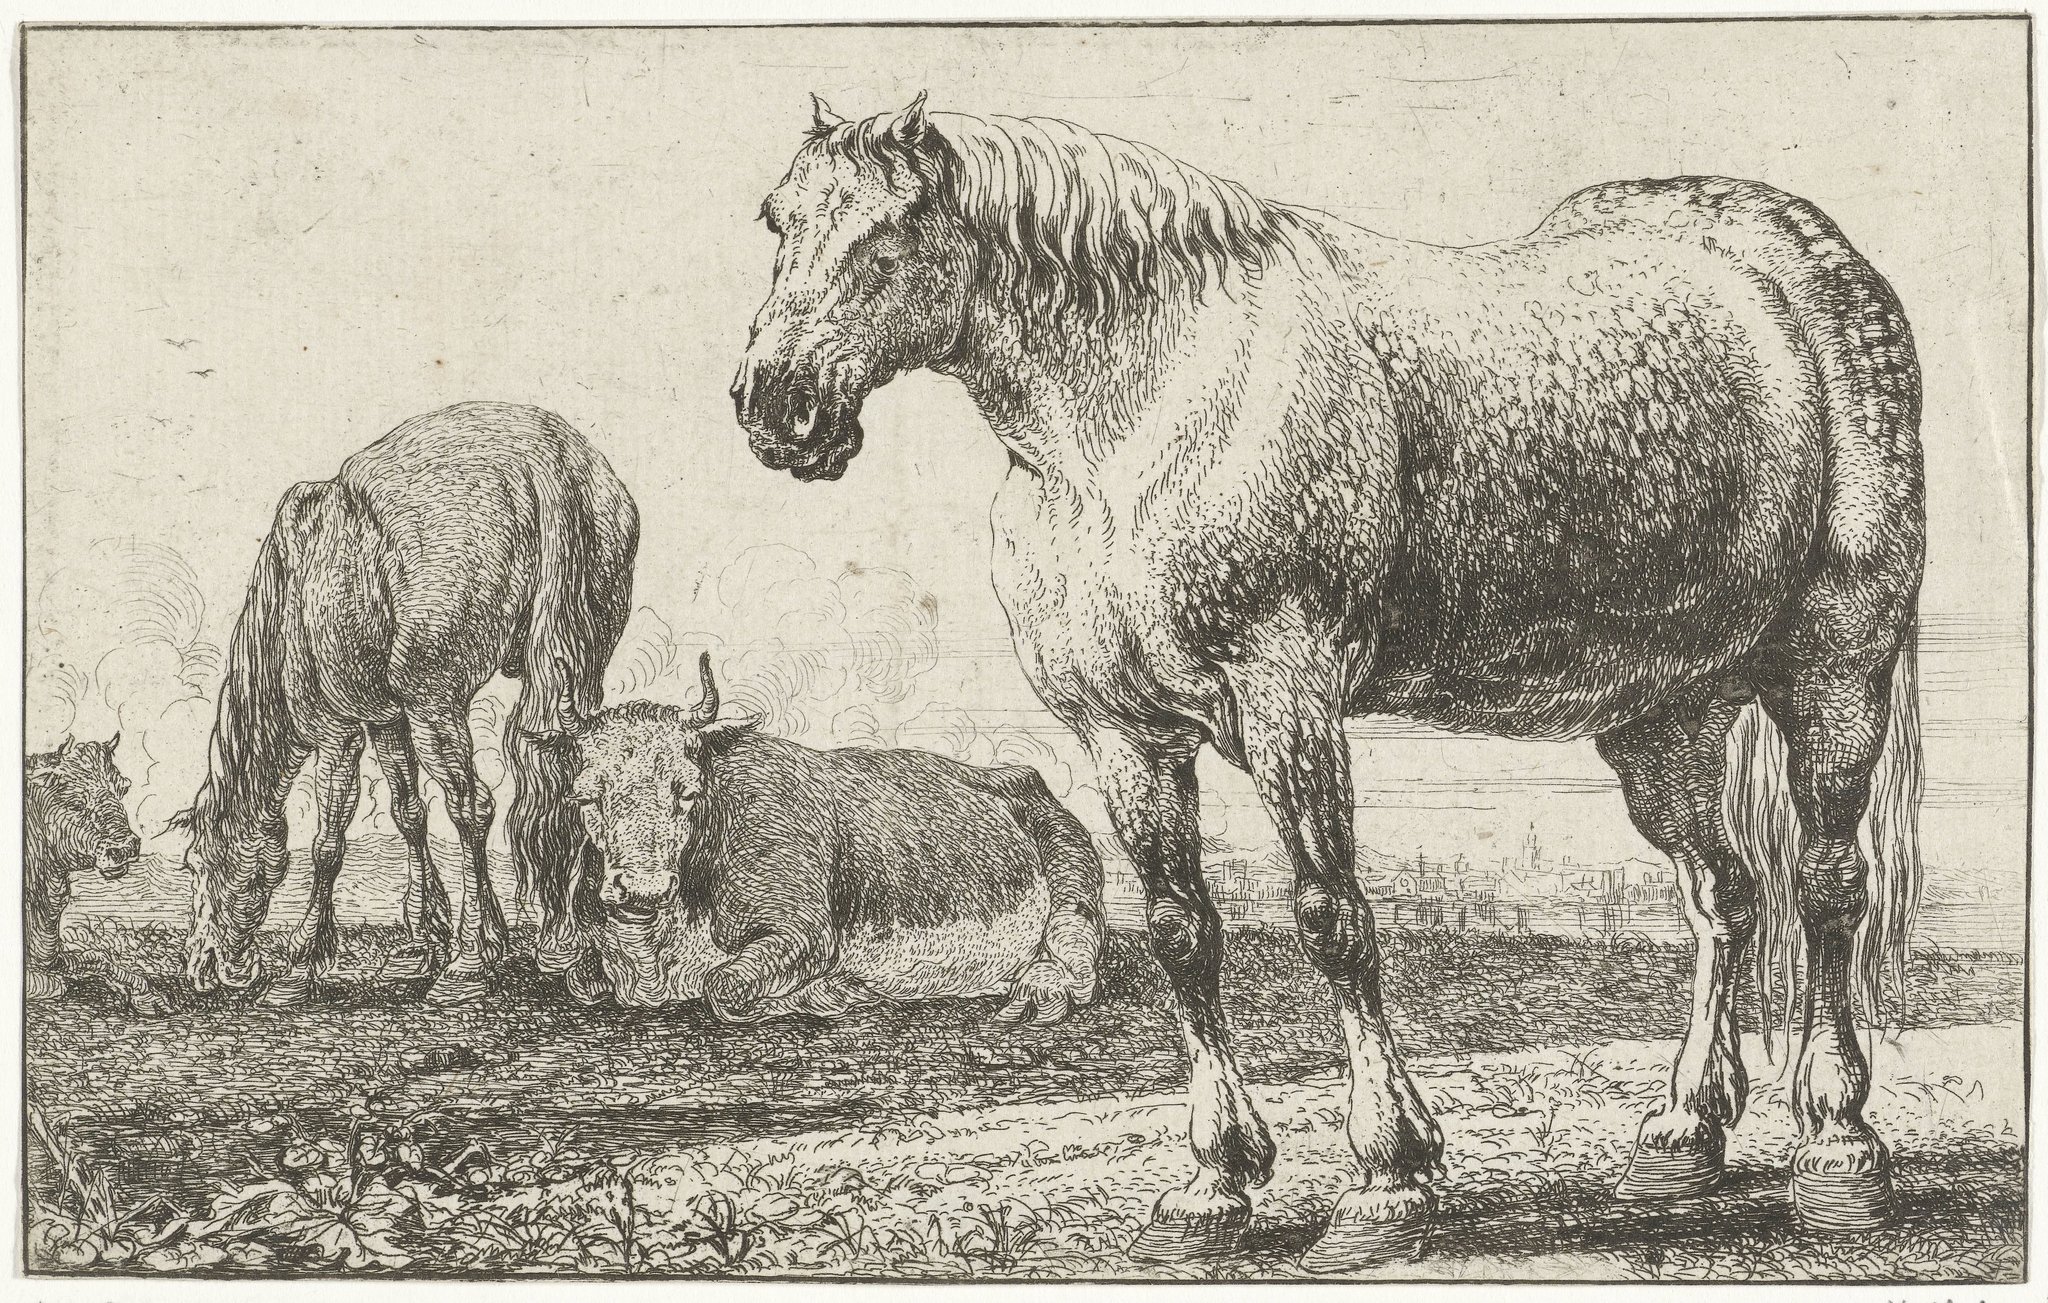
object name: print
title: Dieren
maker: jan van den hecke (i)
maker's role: print maker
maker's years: 1619-1684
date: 1656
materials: paper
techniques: etching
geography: brussels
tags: cow, horse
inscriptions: collector's mark: Lugt 240